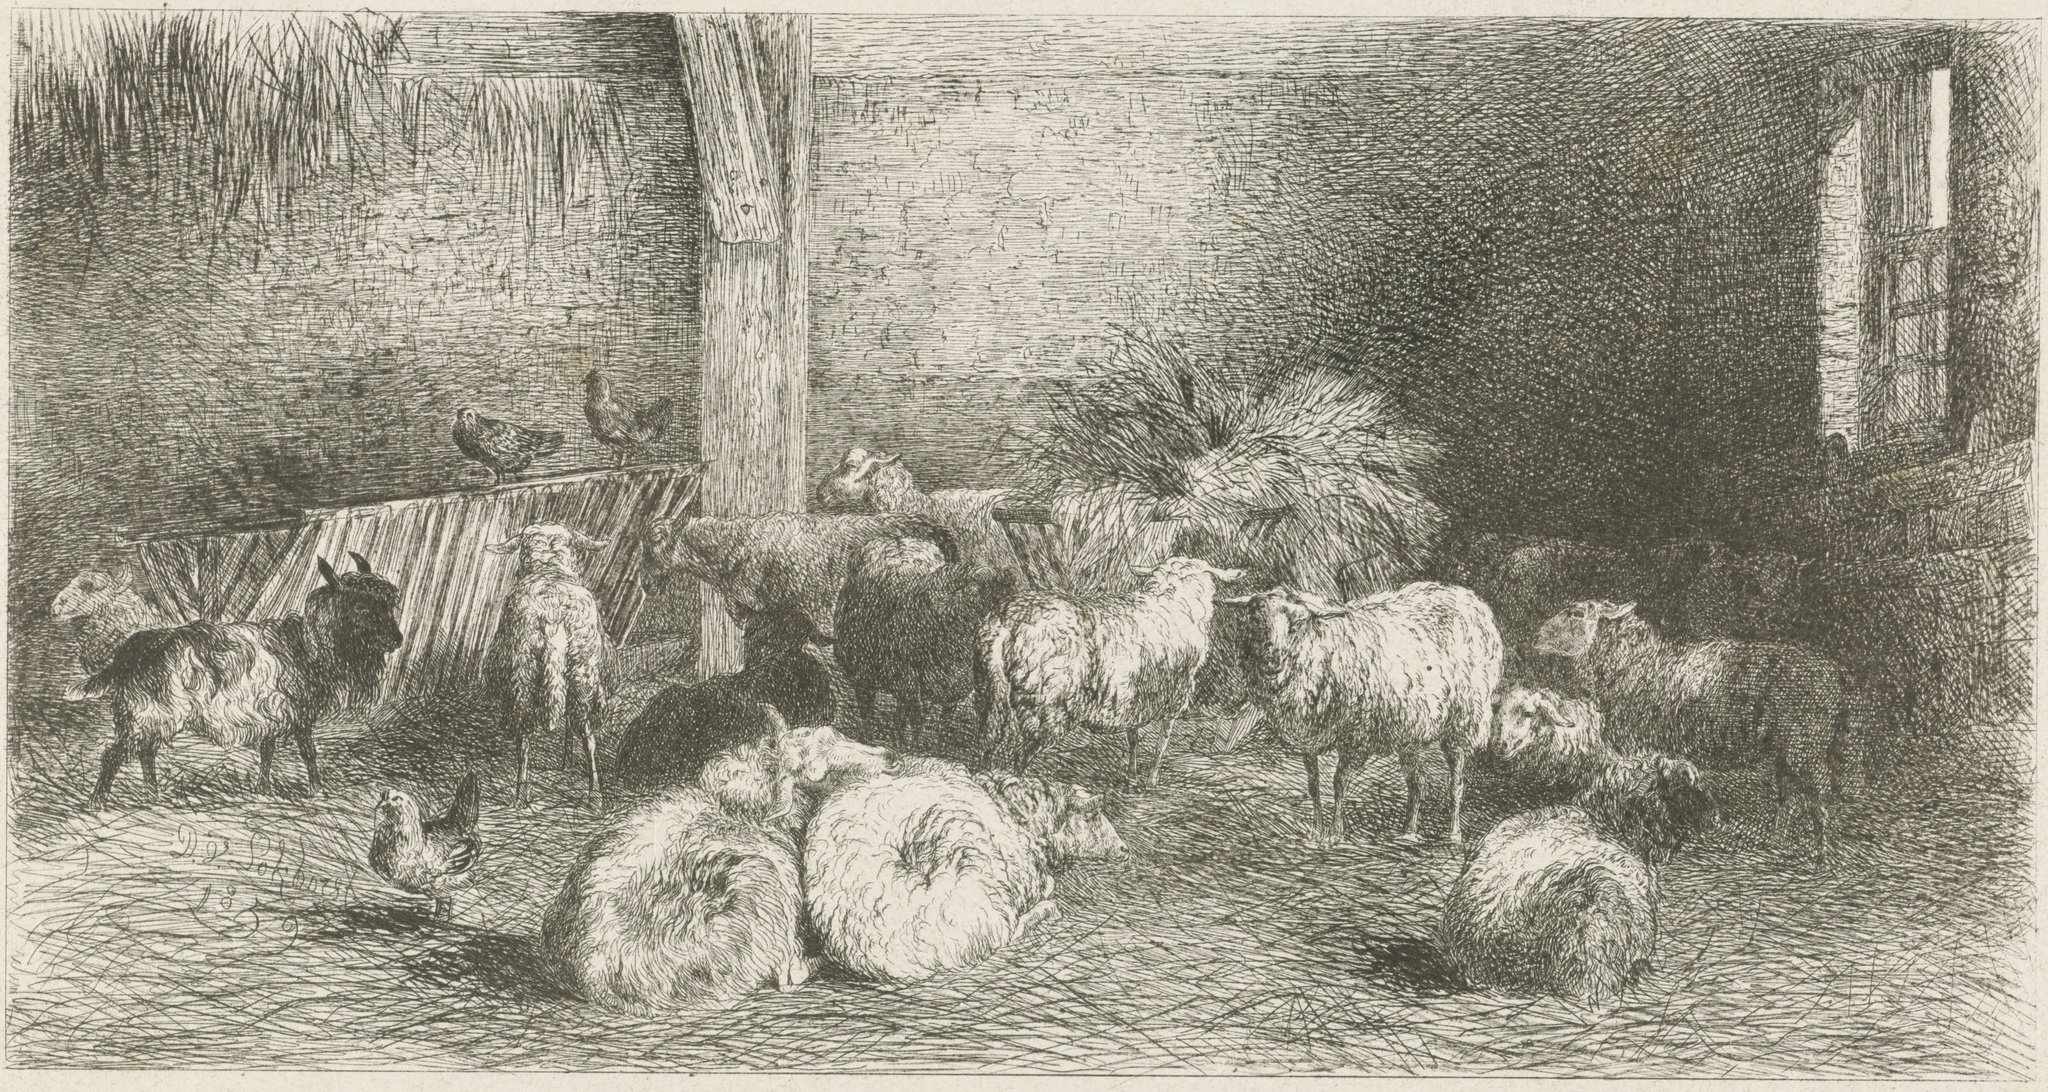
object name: print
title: Stal met schapen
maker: dirk van lokhorst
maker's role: draughtsman, painter, print maker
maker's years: 1818-1893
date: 1859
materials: paper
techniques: etching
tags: barn, cattle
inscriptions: collector's mark: Lugt 2228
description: Een stal gevuld met schapen en enkele kippen.